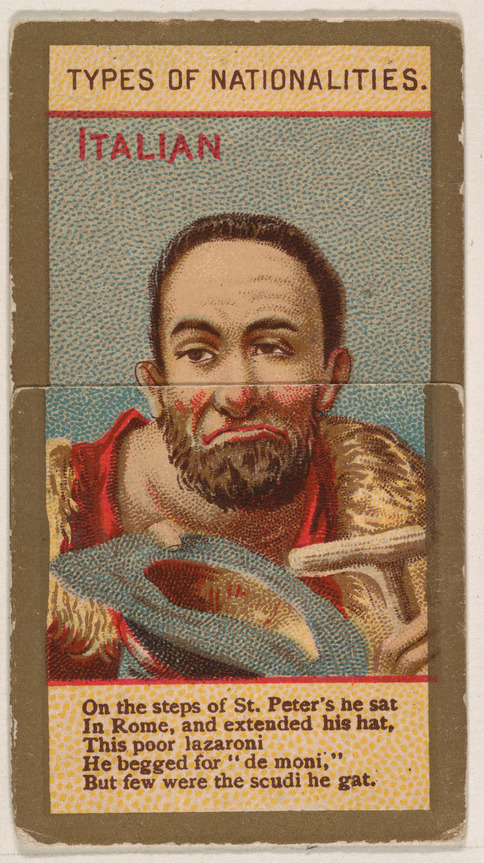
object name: print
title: Italian, from Types of Nationalities (N240) issued by Kinney Bros.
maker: kinney brothers tobacco company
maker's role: publisher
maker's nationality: american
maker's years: 1869-2011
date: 1890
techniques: color lithograph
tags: men